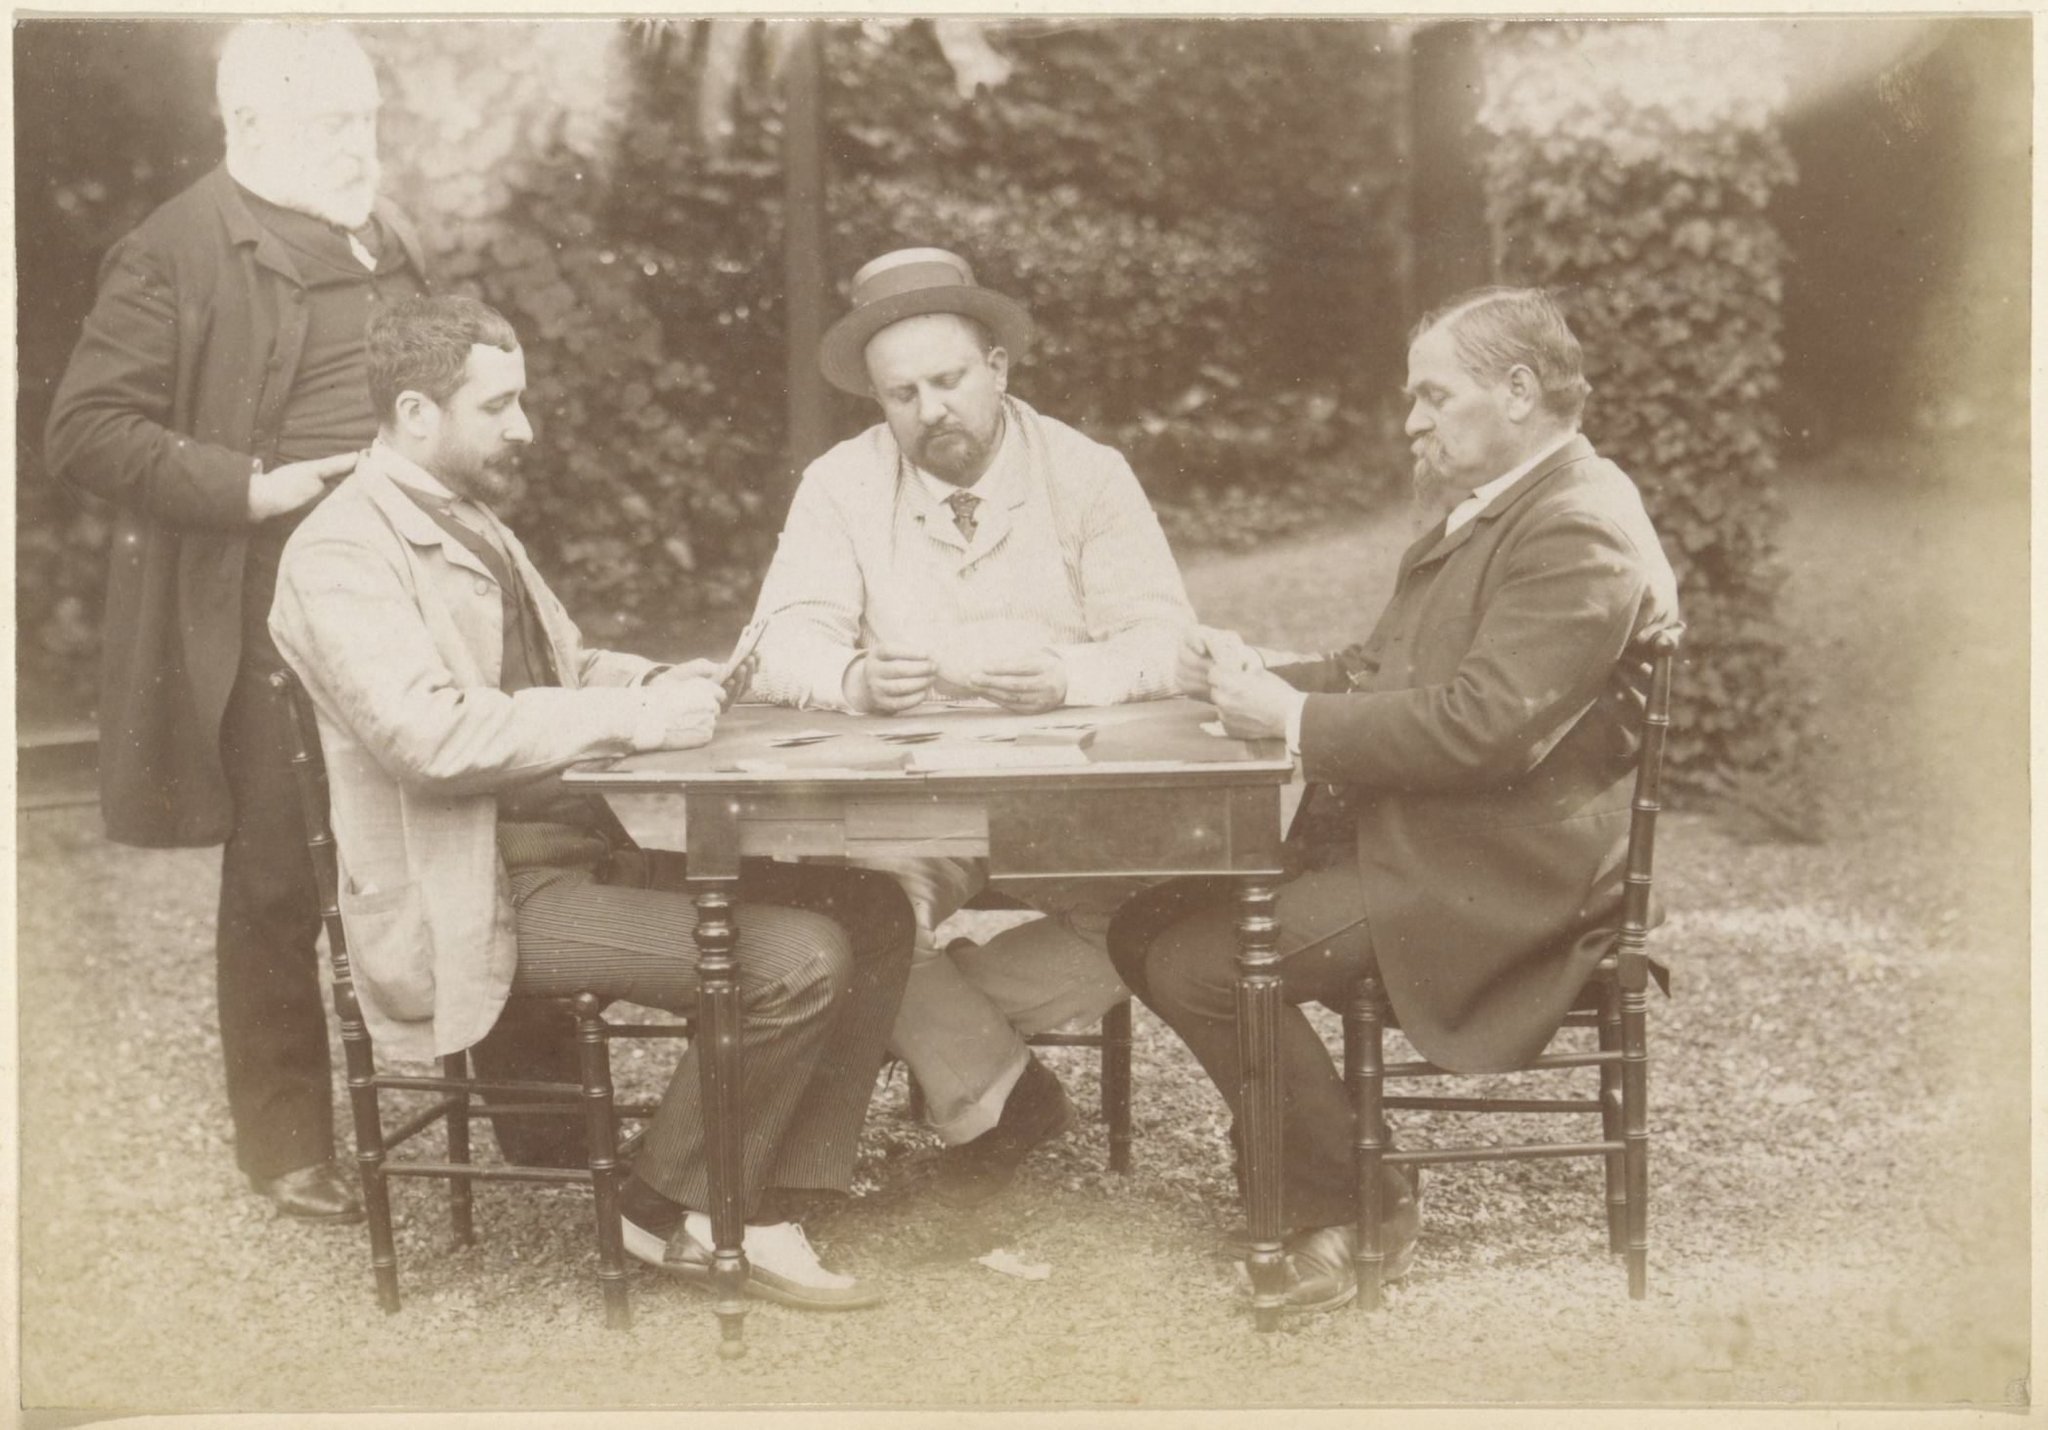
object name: photograph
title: Drie mannen kaartend aan tafel in een tuin in Frankrijk, één man kijkt toe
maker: Anonymous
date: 1900-1910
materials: paper, photographic support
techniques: albumen print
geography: france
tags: garden, card games, france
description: Onderdeel van Fotoalbum van een Franse amateurfotograaf met opnames van een familie, distilleerderij Delizy & Doistau Fils, het leger en bezienswaardigheden in Frankrijk.